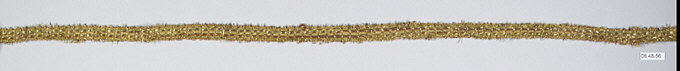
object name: galloon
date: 1701-1800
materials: silk